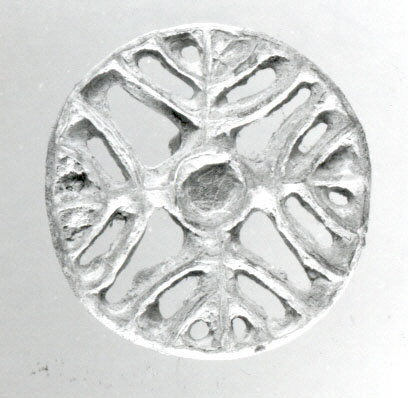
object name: stamp seal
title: Compartmented stamp seal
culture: bactria-margiana archaeological complex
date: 2333-1668 BCE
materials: copper alloy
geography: bactria-margiana